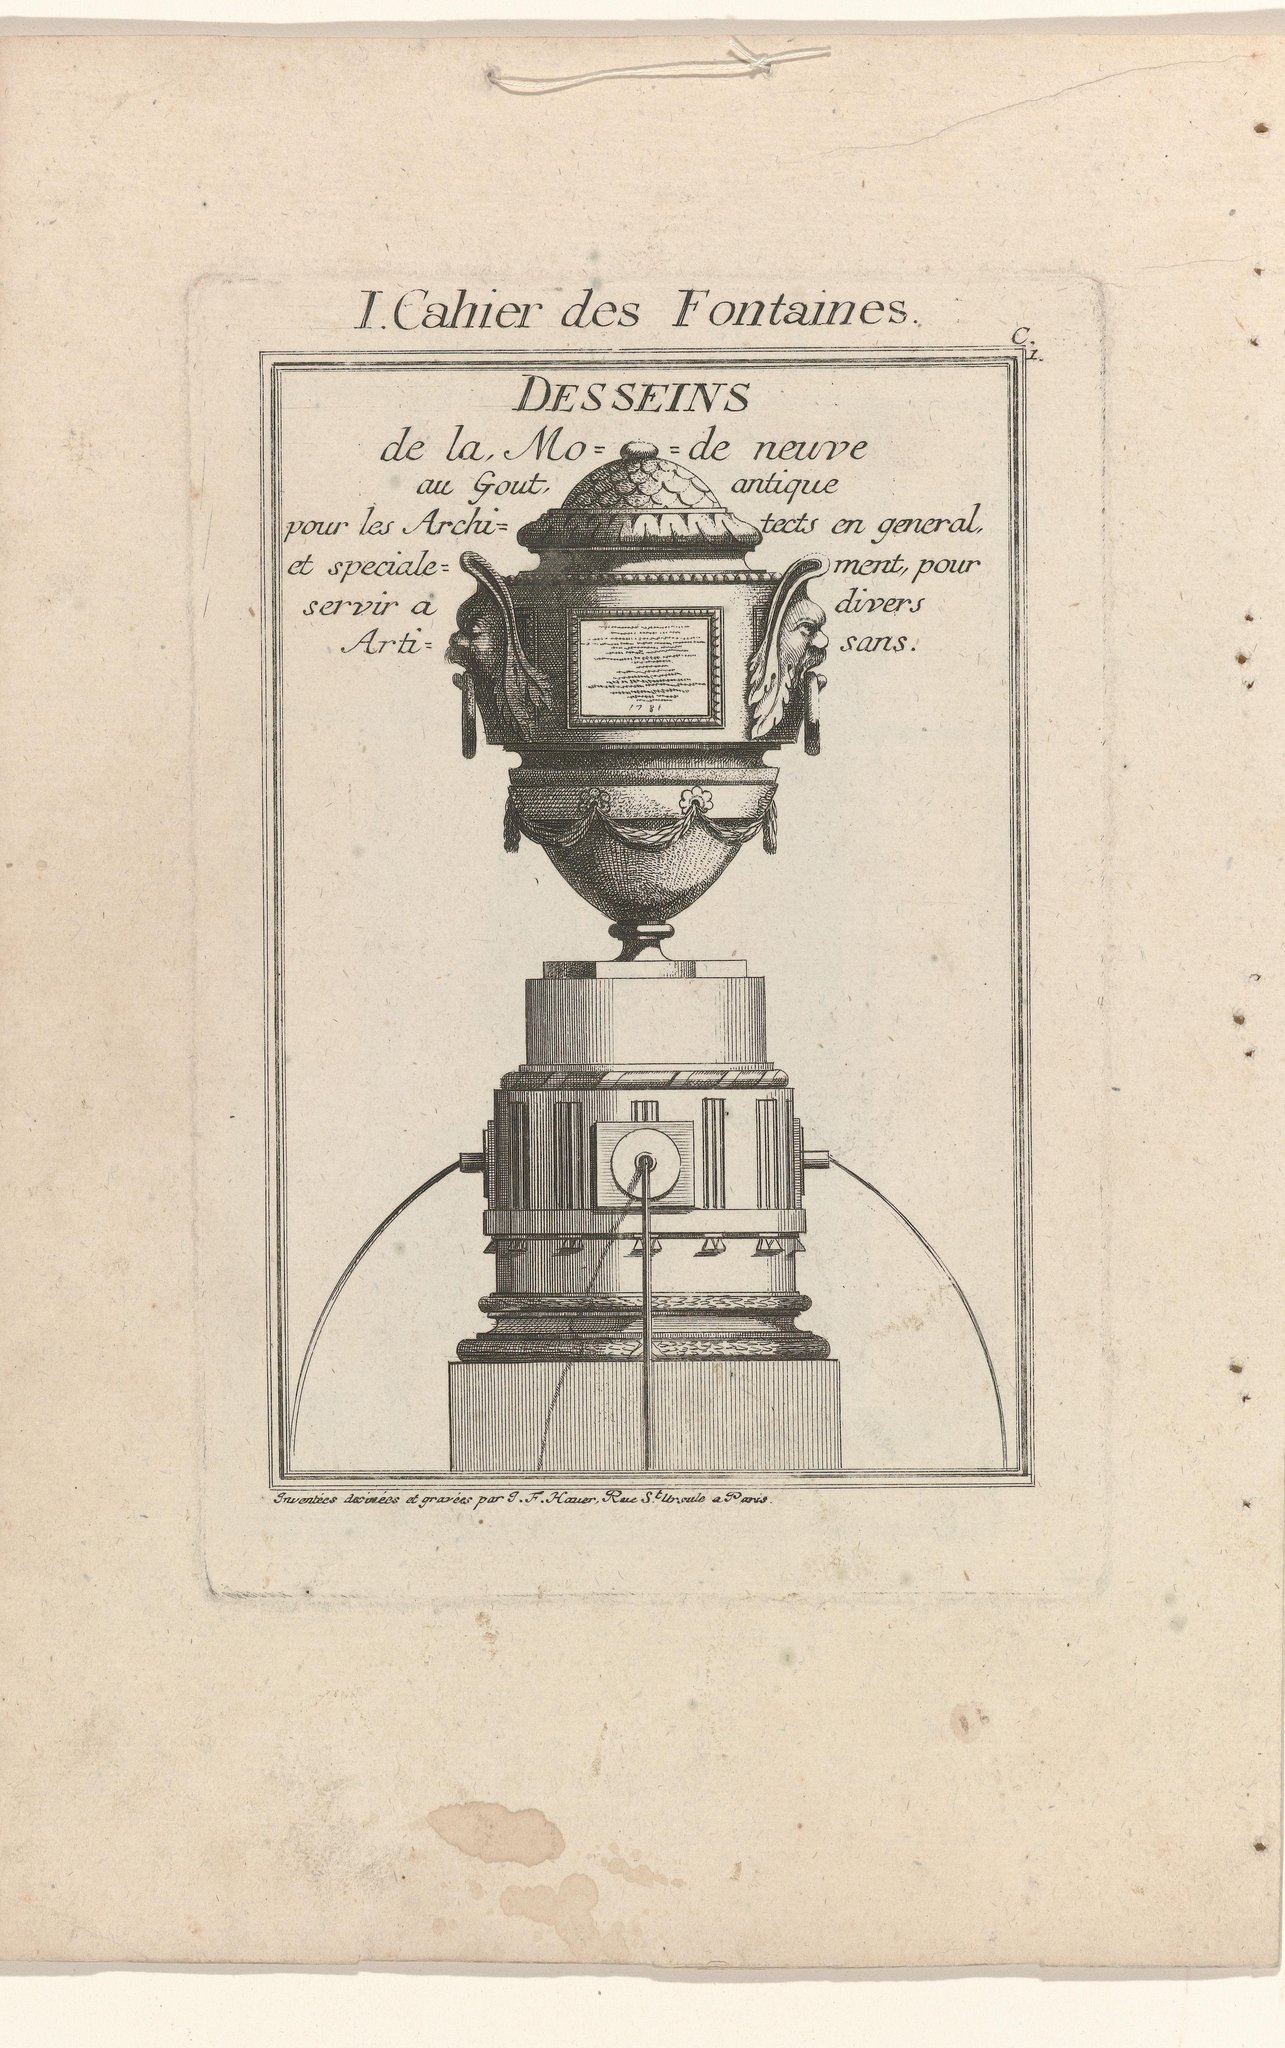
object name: ornament print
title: I Cahier des Fontaines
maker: johann thomas hauer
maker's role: print maker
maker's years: 1748-1820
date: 1781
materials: paper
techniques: engraving, etching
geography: paris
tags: ornamental fountain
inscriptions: collector's mark: Lugt 2228, collector's mark: Lugt 2760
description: Ontwerp voor een pedestal met drie waterstromen met bovenop een antieke vaas met twee maskers.